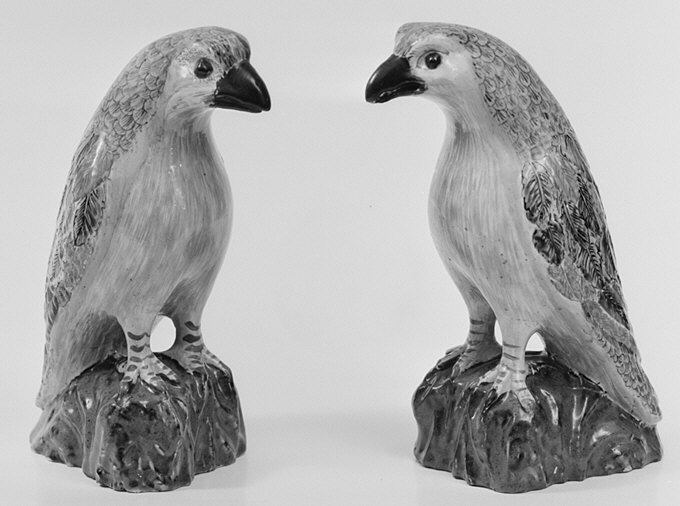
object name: figure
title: Pair of hawks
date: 1750-1760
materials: stoneware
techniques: salt glaze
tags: hawks